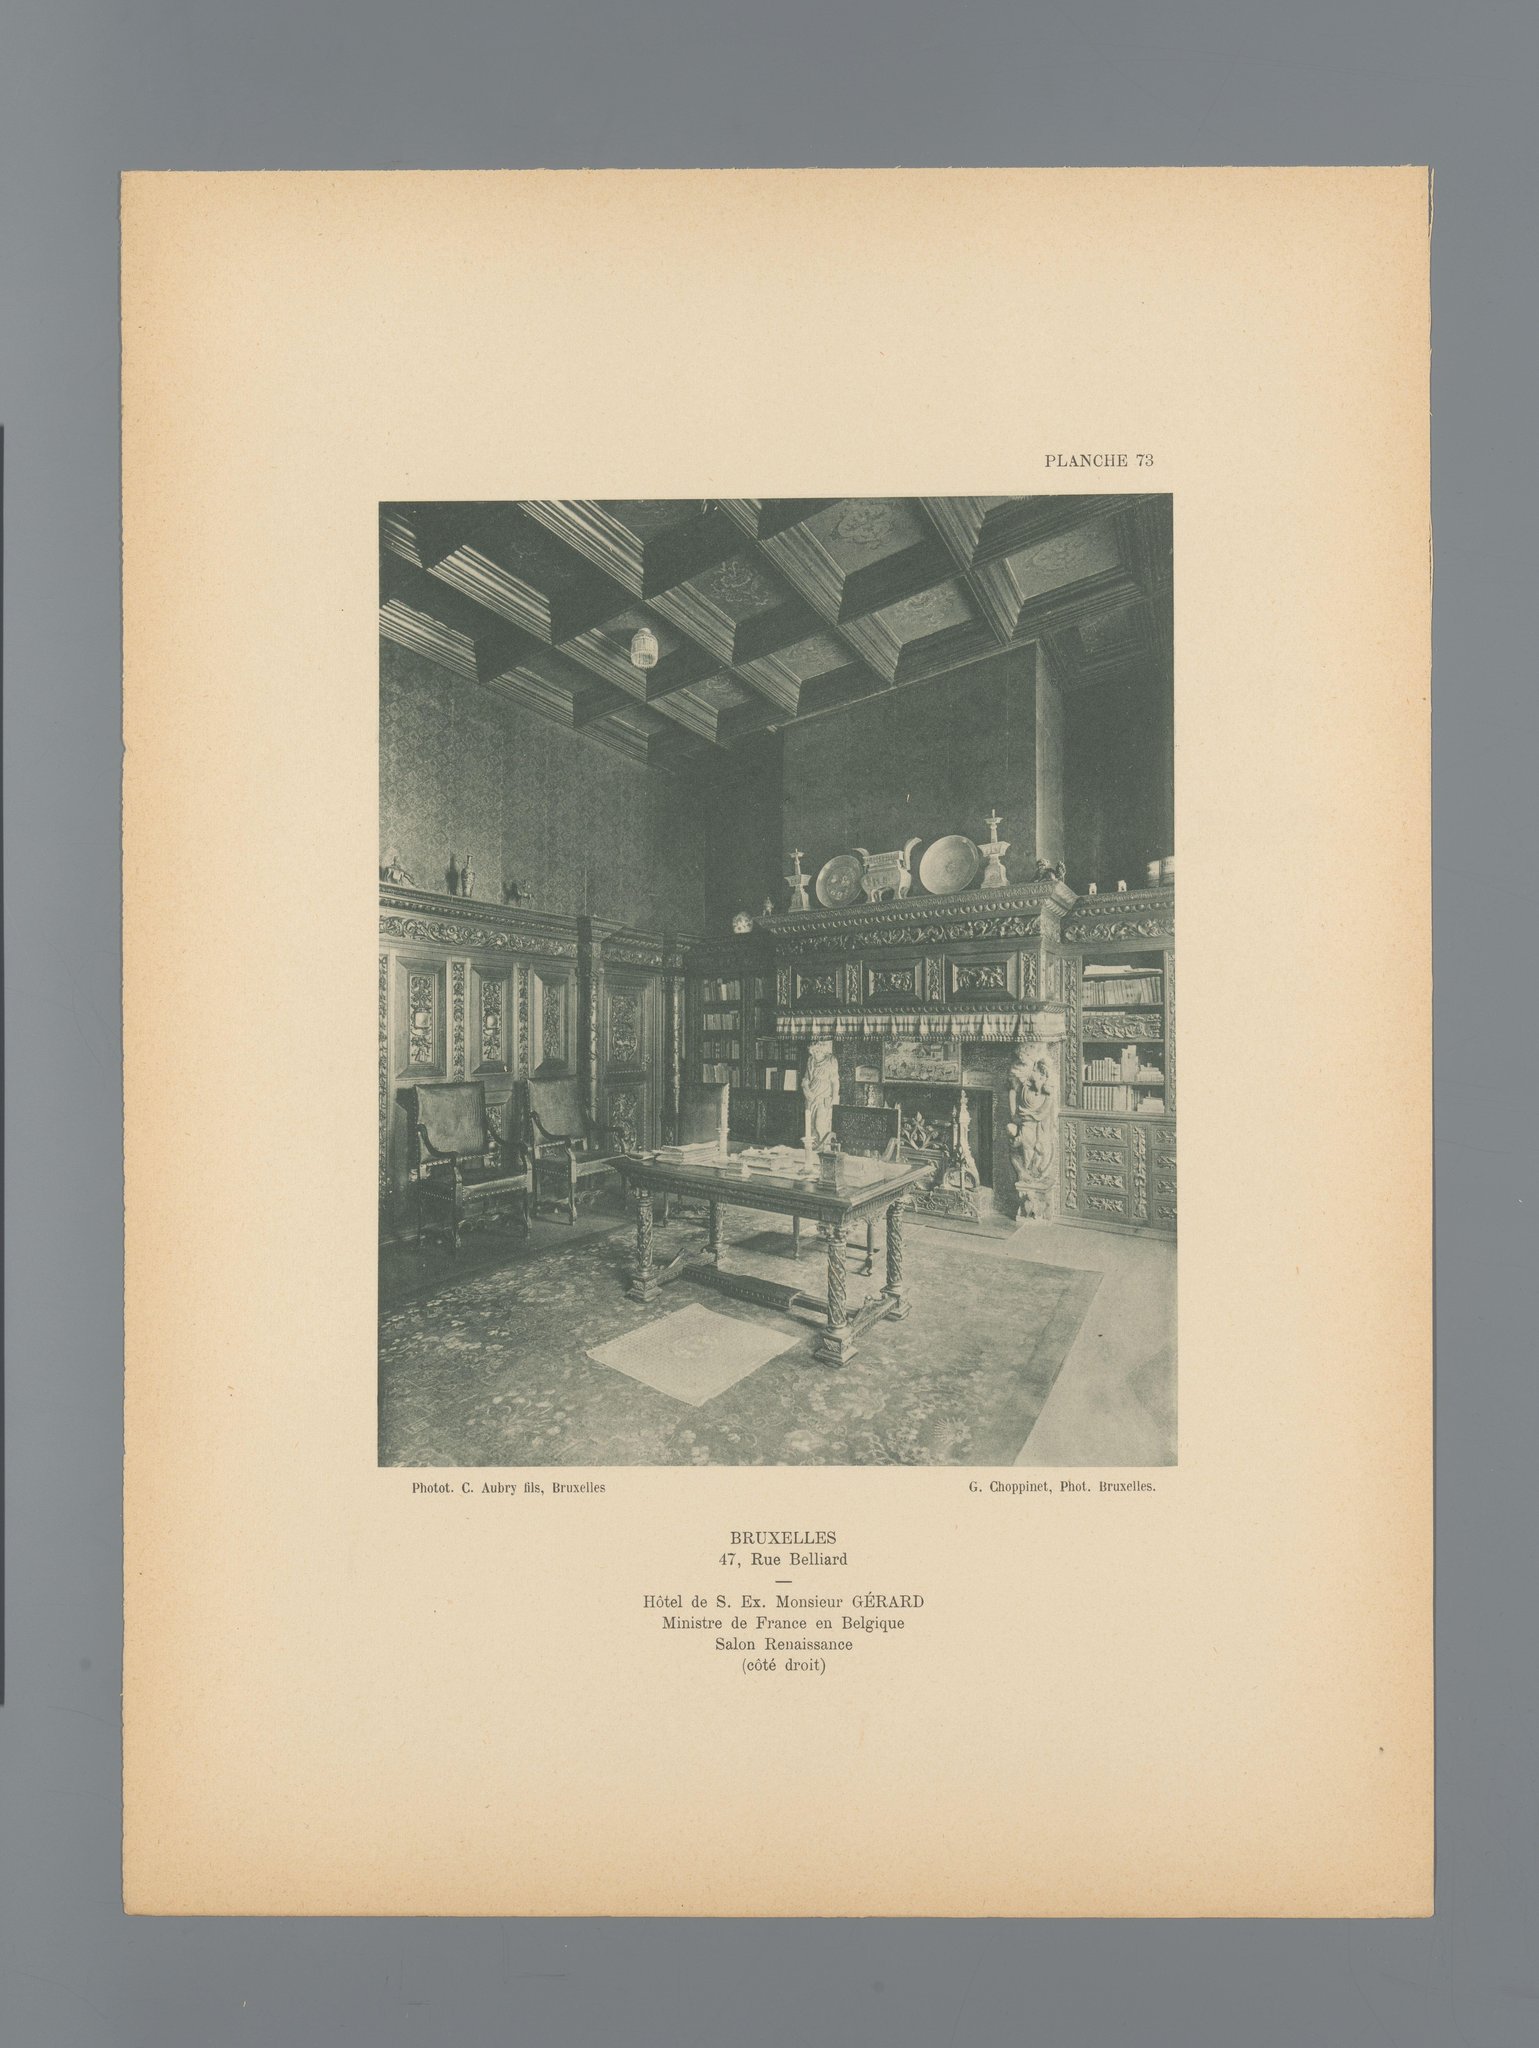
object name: photomechanical print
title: Gezicht op een zaal in renaissancestijl in het hotel van Léon Gérard in Brussel, België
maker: gustave choppinet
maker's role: fotograaf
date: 1893-1898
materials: paper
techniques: photograph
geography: brussels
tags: interior of the house, hotel, hostelry, inn, brussels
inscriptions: inscription: ‘47, Rue Belliard/ Hôtel de S. Ex. Monsieur GÉRARD/ Ministre de France en Belgique/ Salon Renaissance/ (côté droit)’, number: ‘PLANCHE 73’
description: Deze prent maakt deel uit van een omslag met 89 prenten en 5 tekstbladen.